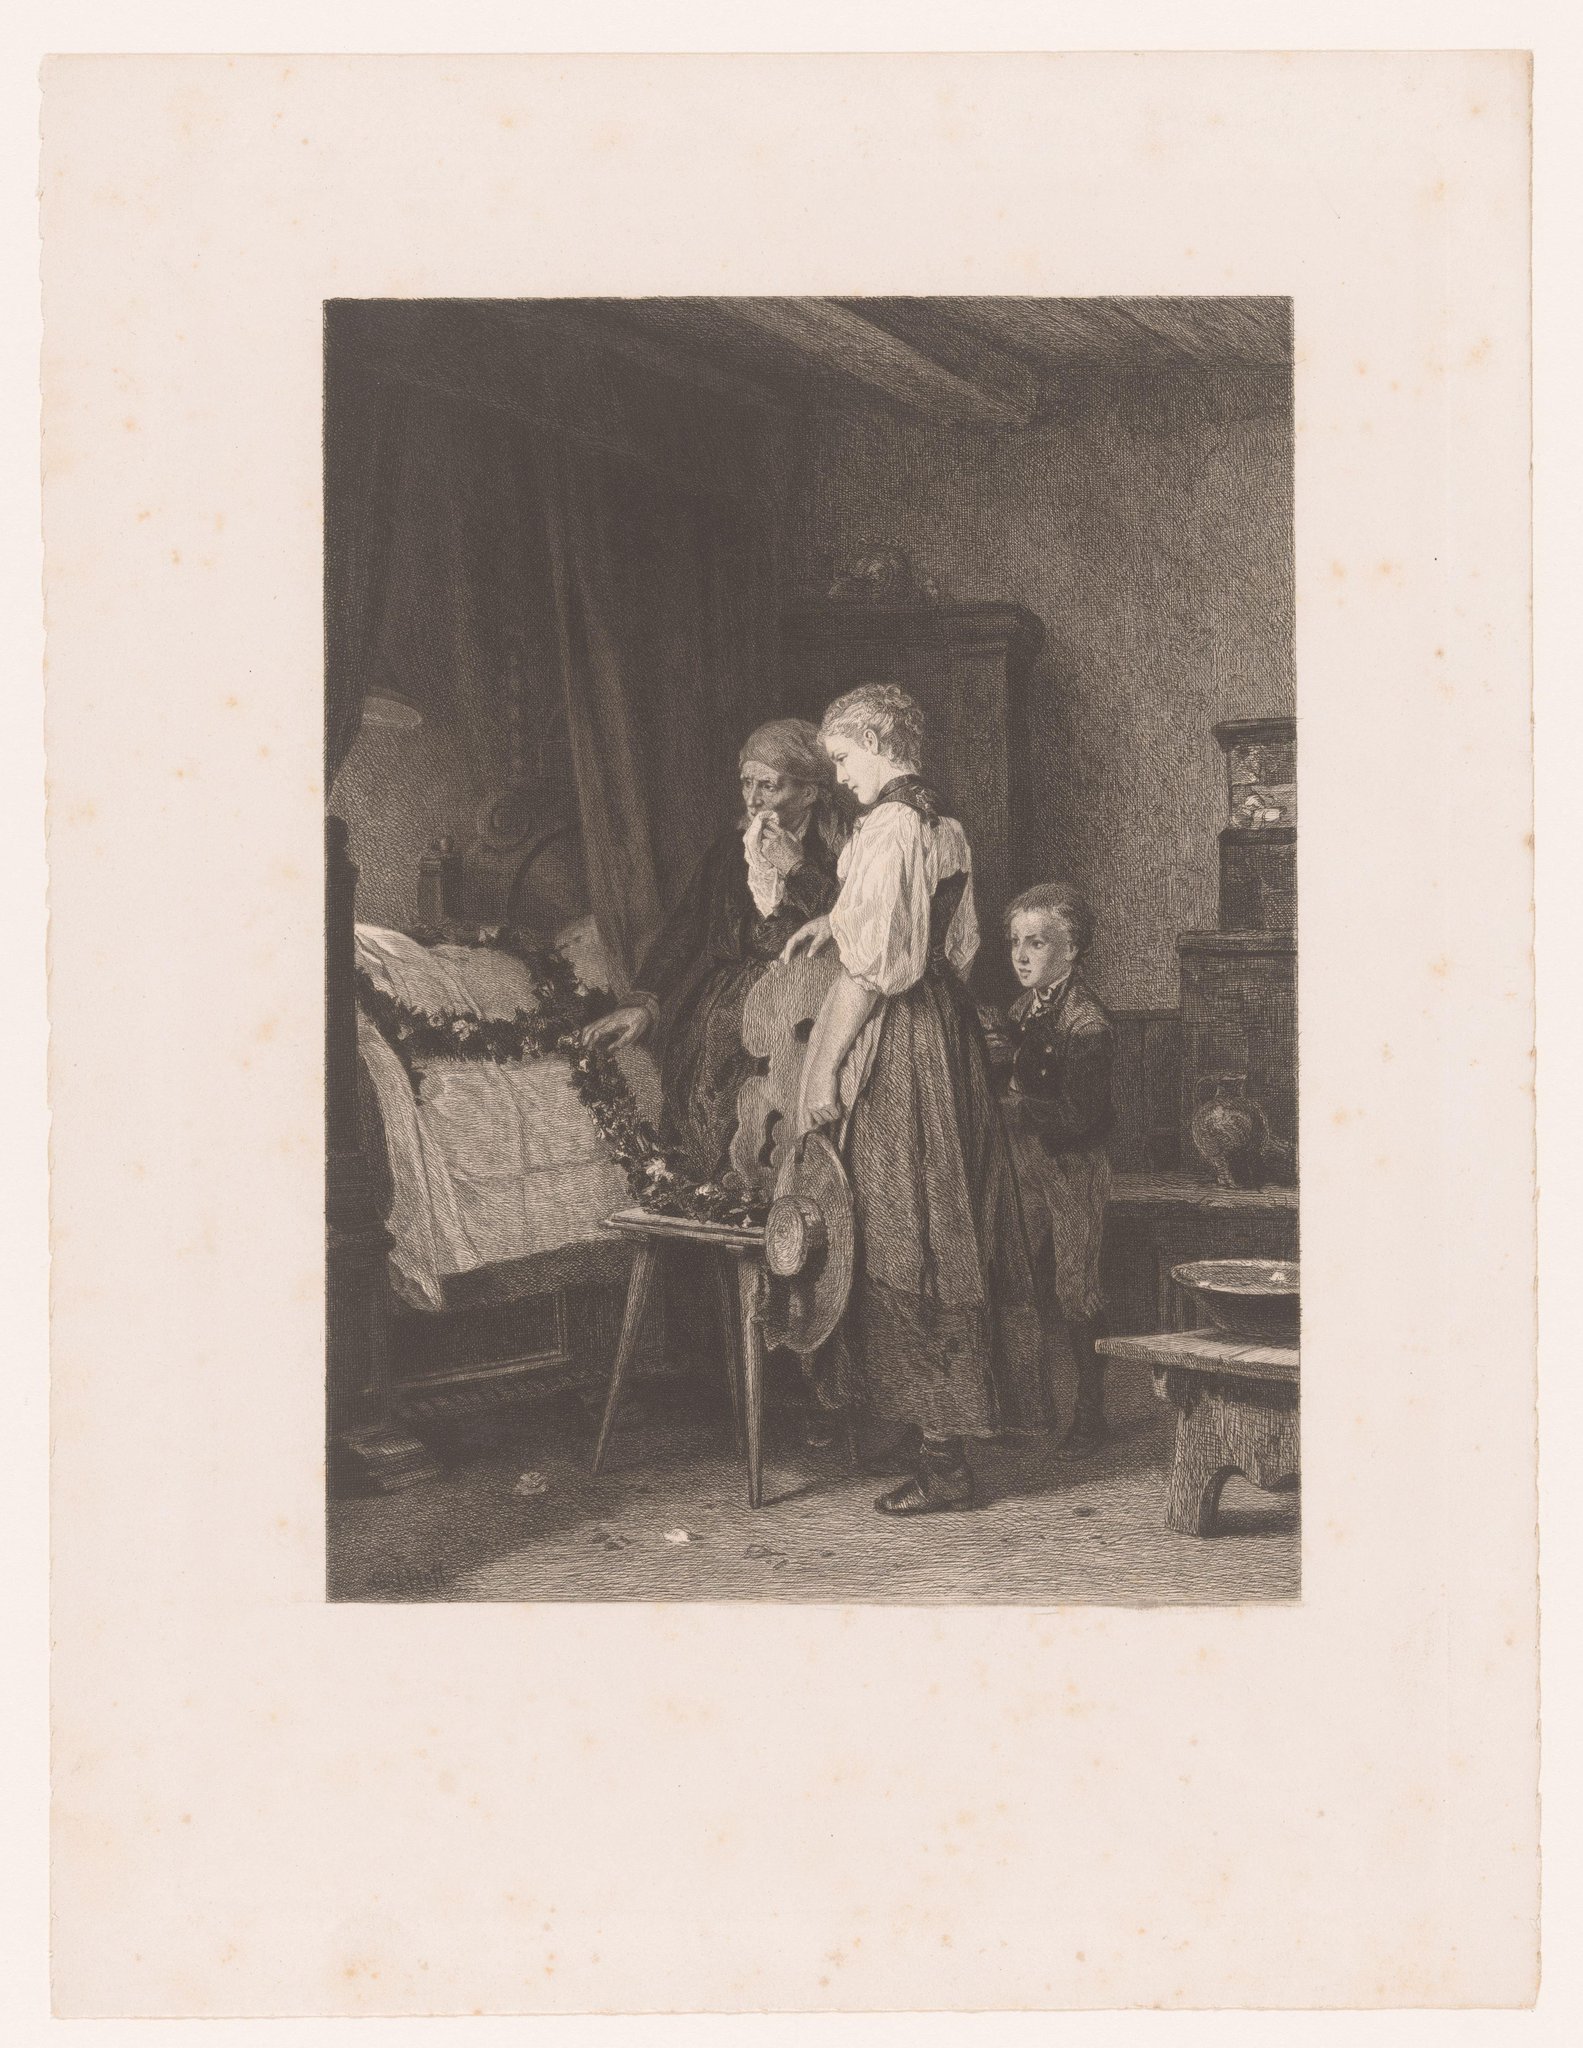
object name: print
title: Familie aan een sterfbed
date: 1808-1873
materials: paper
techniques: etching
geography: germany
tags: deathbed, family life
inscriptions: collector's mark: Lugt 2228